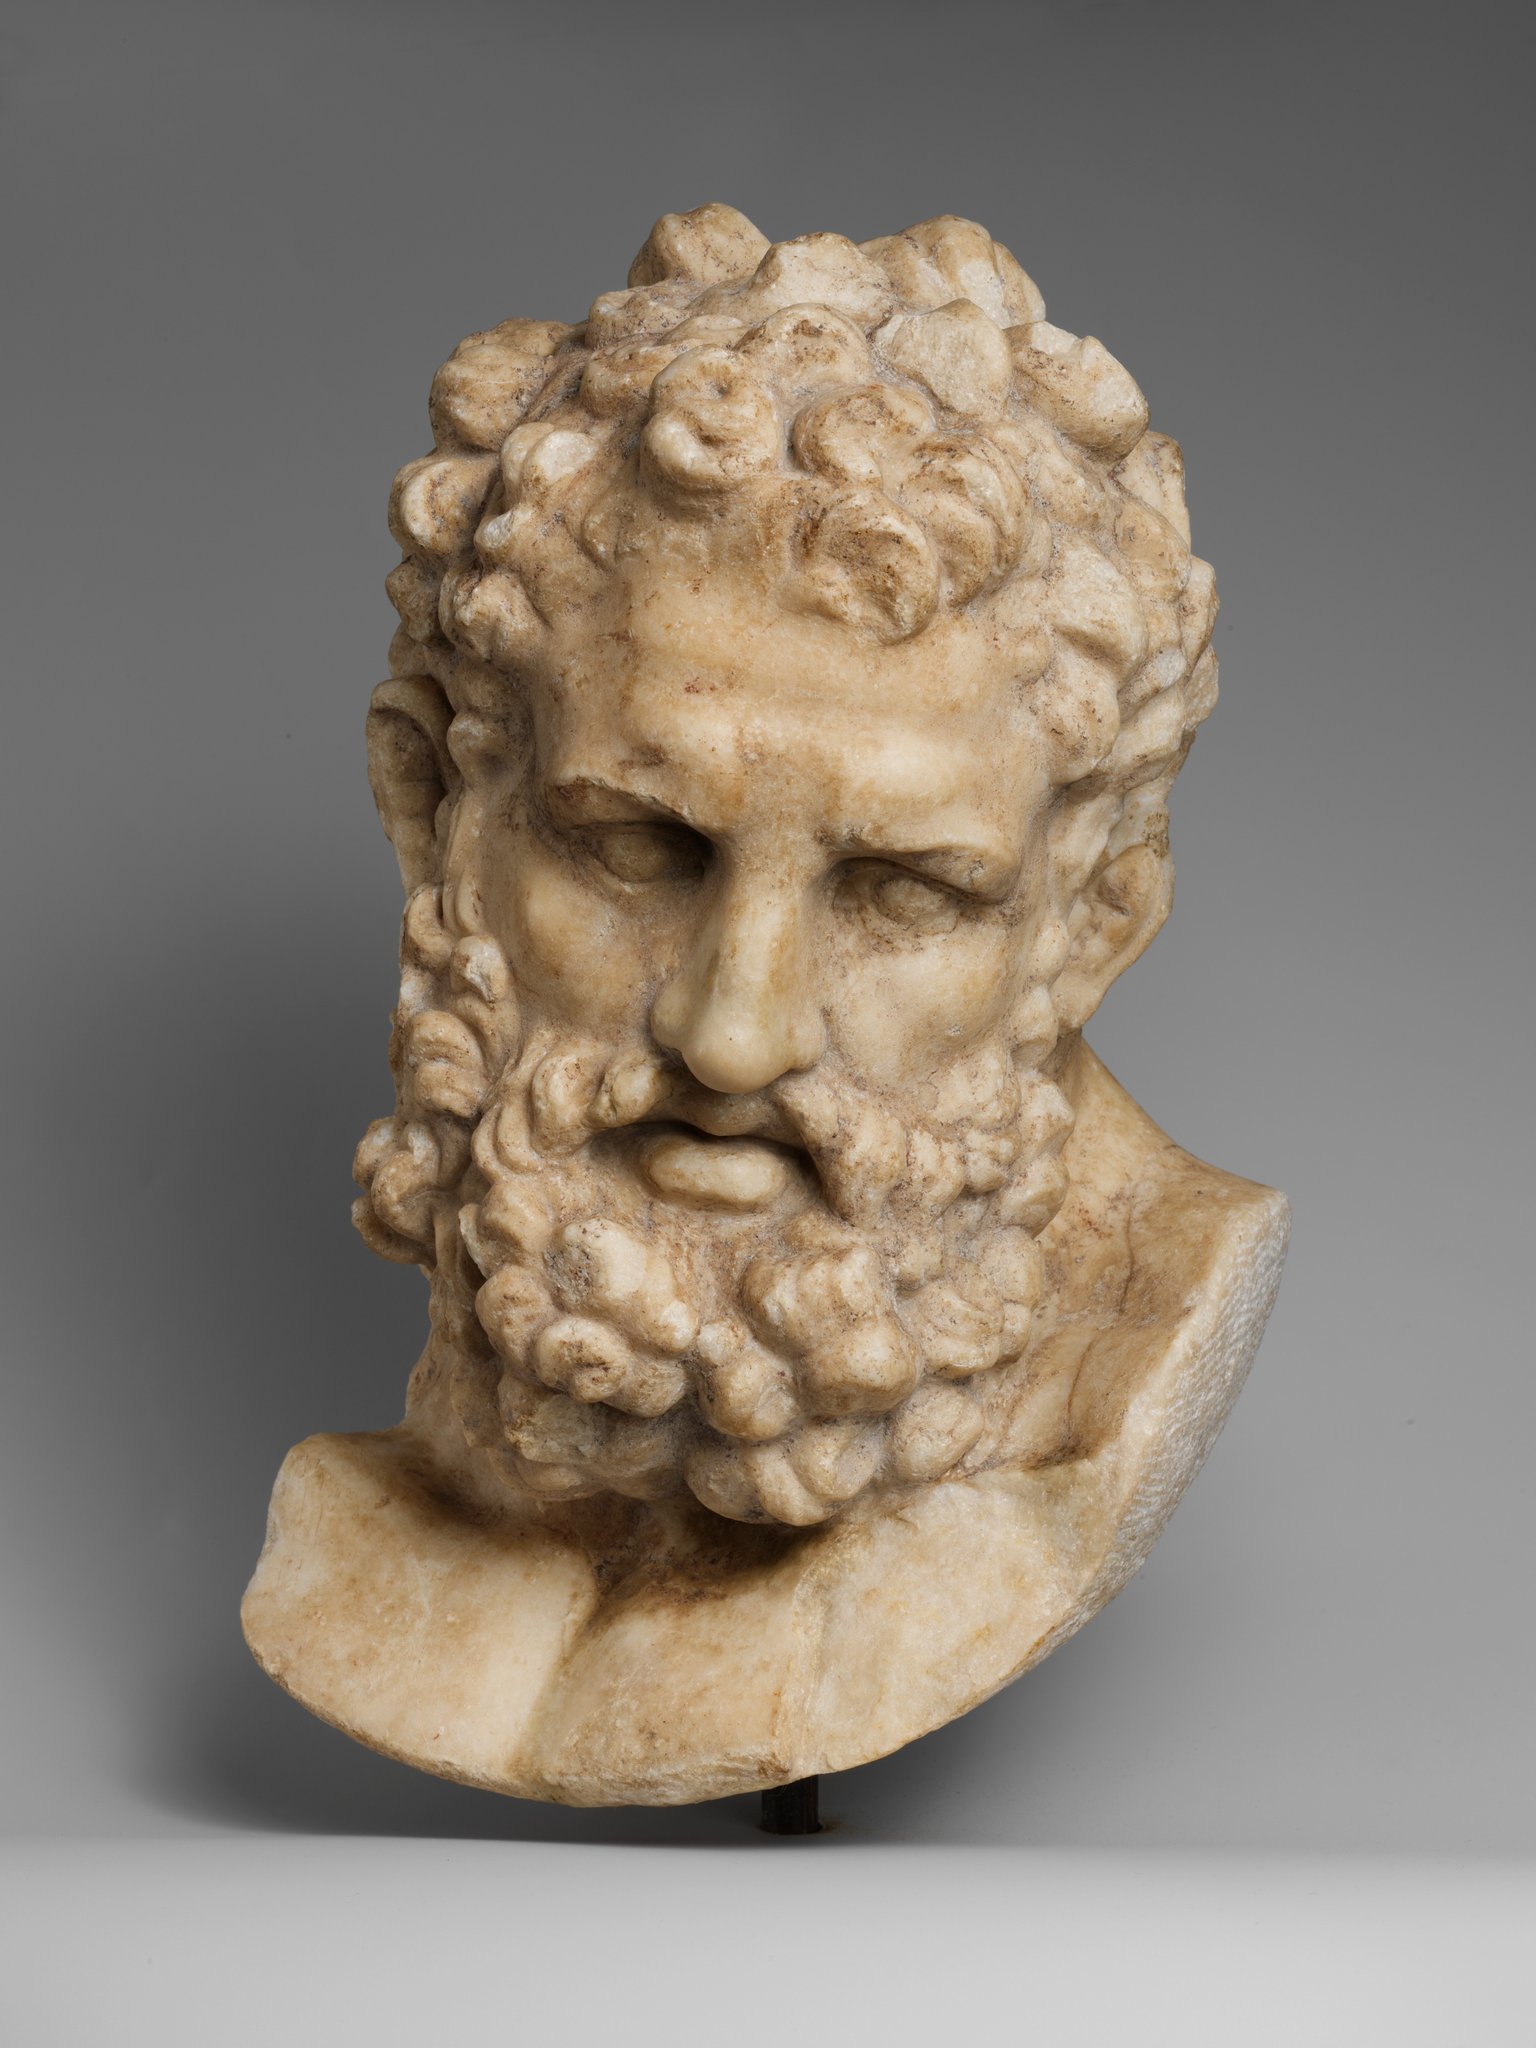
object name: bust of herakles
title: Marble head of Herakles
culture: roman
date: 1-100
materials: marble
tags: heads,herakles